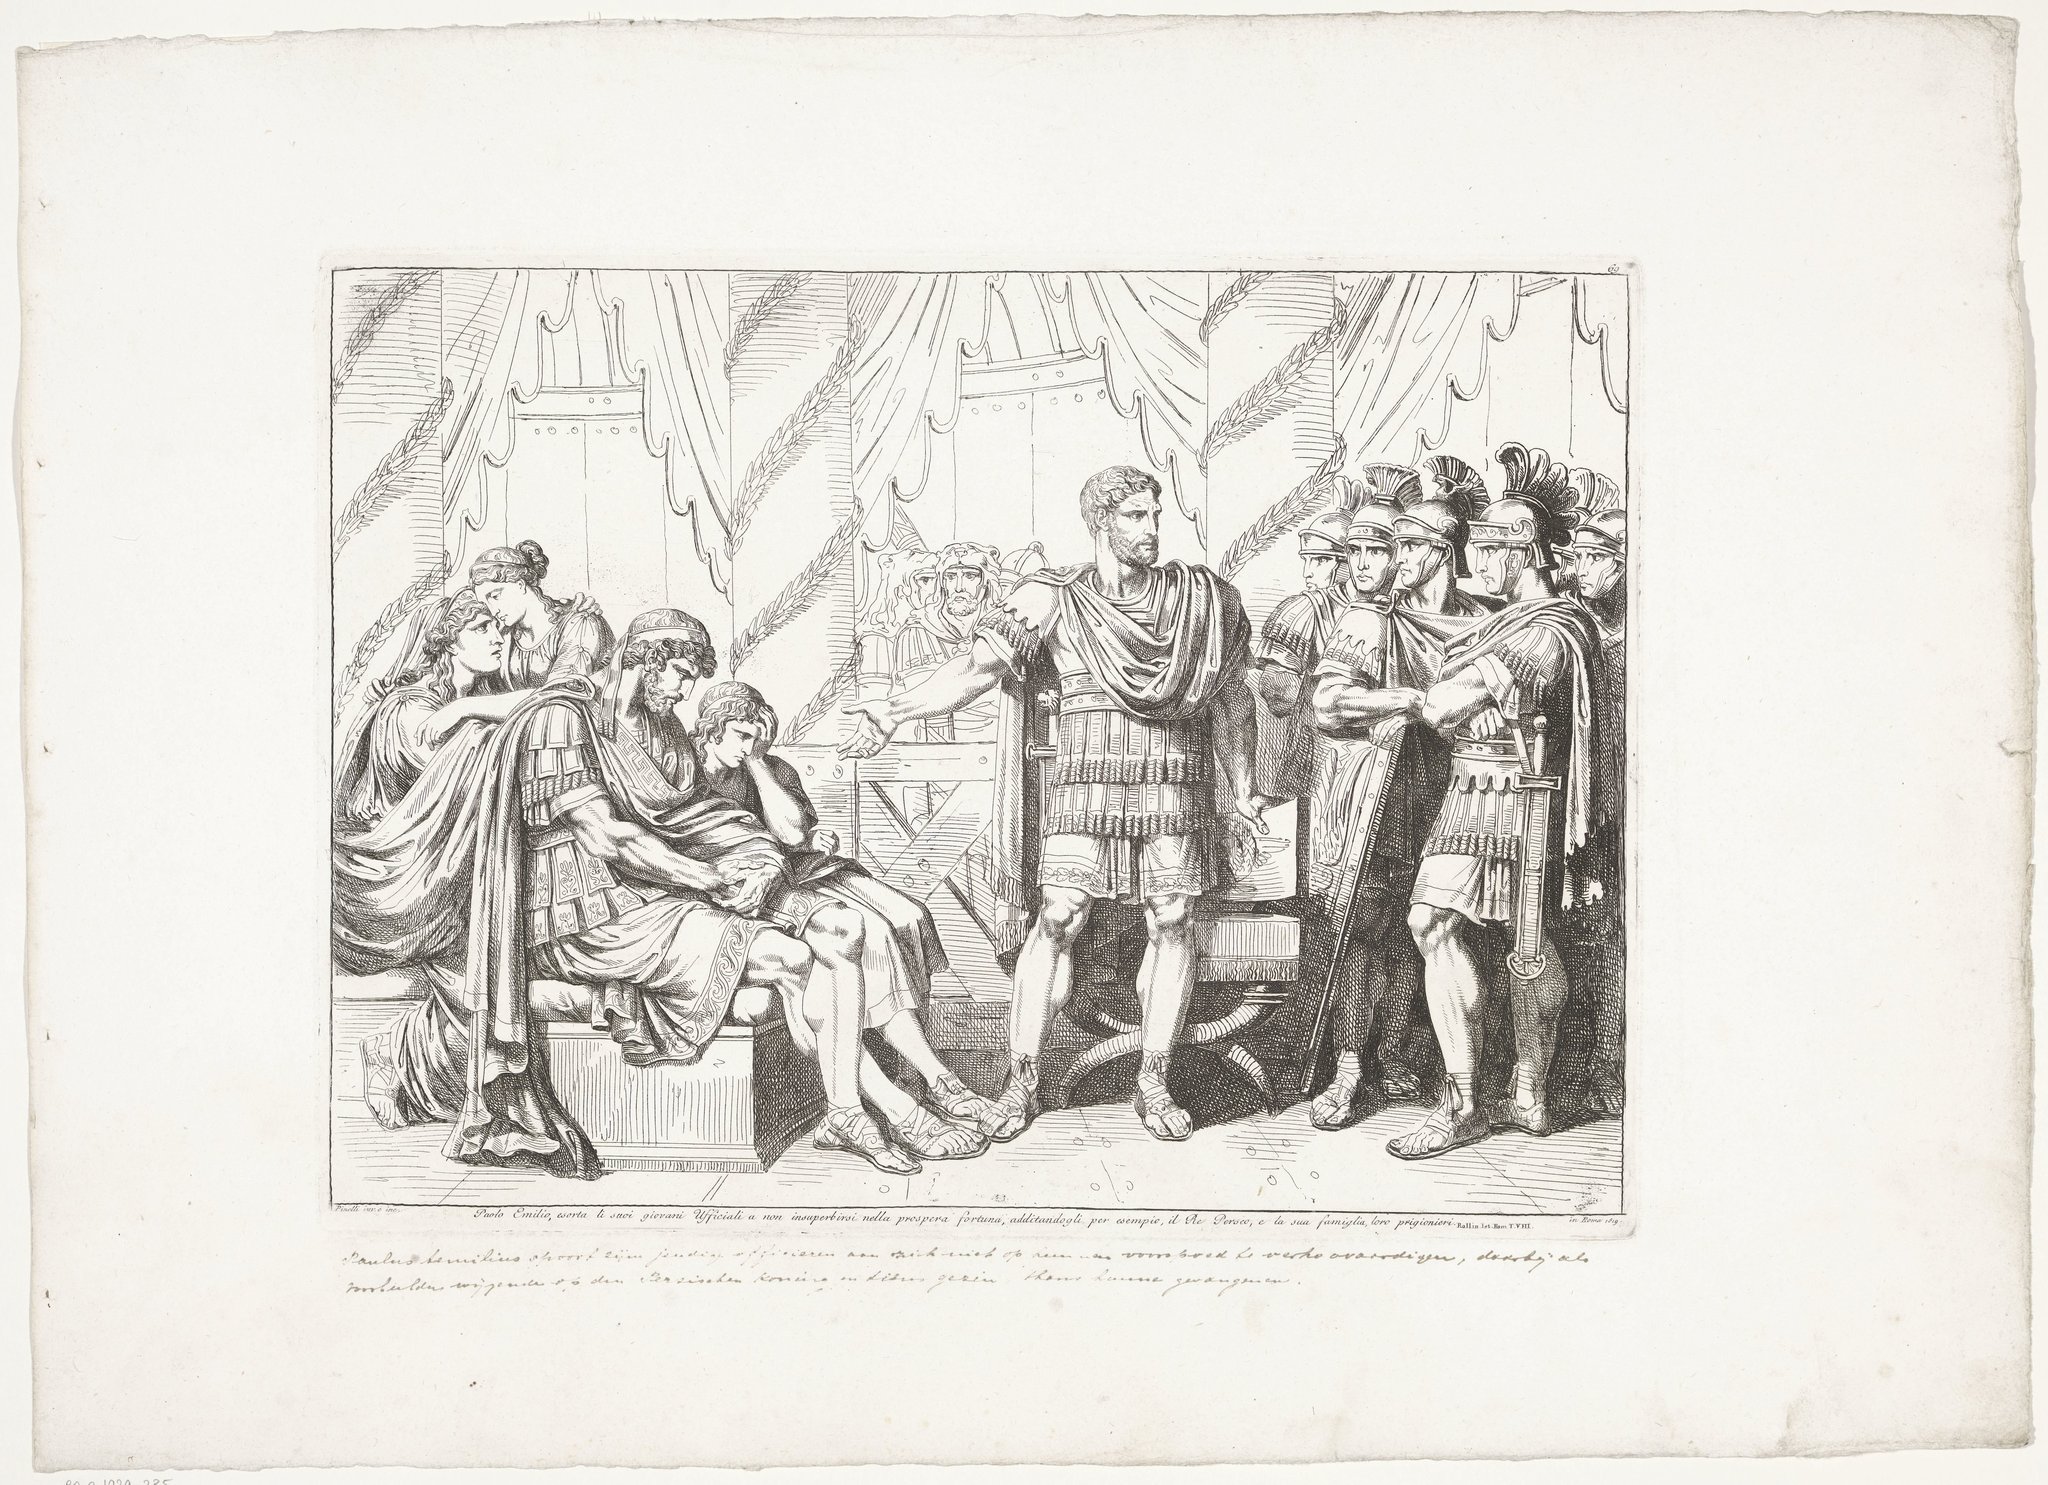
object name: print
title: Paolo Emilio, esorta li suoi giovani Ufficiali a non insuperbirsi nella prospera fortuna, additandogli per esempio, il Re Perseo, e la sua famiglia loro prigionieri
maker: bartolomeo pinelli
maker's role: draughtsman, print maker, sculptor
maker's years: 1781-1835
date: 1819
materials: paper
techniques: etching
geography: rome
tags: (story of) lucius aemilius paul(l)us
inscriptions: collector's mark: Lugt 2228, inscription: ‘Paulus Aemilius spoort zijn jeugdige officieren aan zich niet op [...] voorspoed te verhoovaardigen, daarbij als / voorbeeldens wijzende op den Perzischen koning en diens gezin thans hunne gevangenen.’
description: Lucius Aemilius Paulus I spreekt tegen zijn soldaten over hoogmoed en wijst als voorbeeld naar de koning van Perzië en zijn gezin, die gevangen zijn genomen.